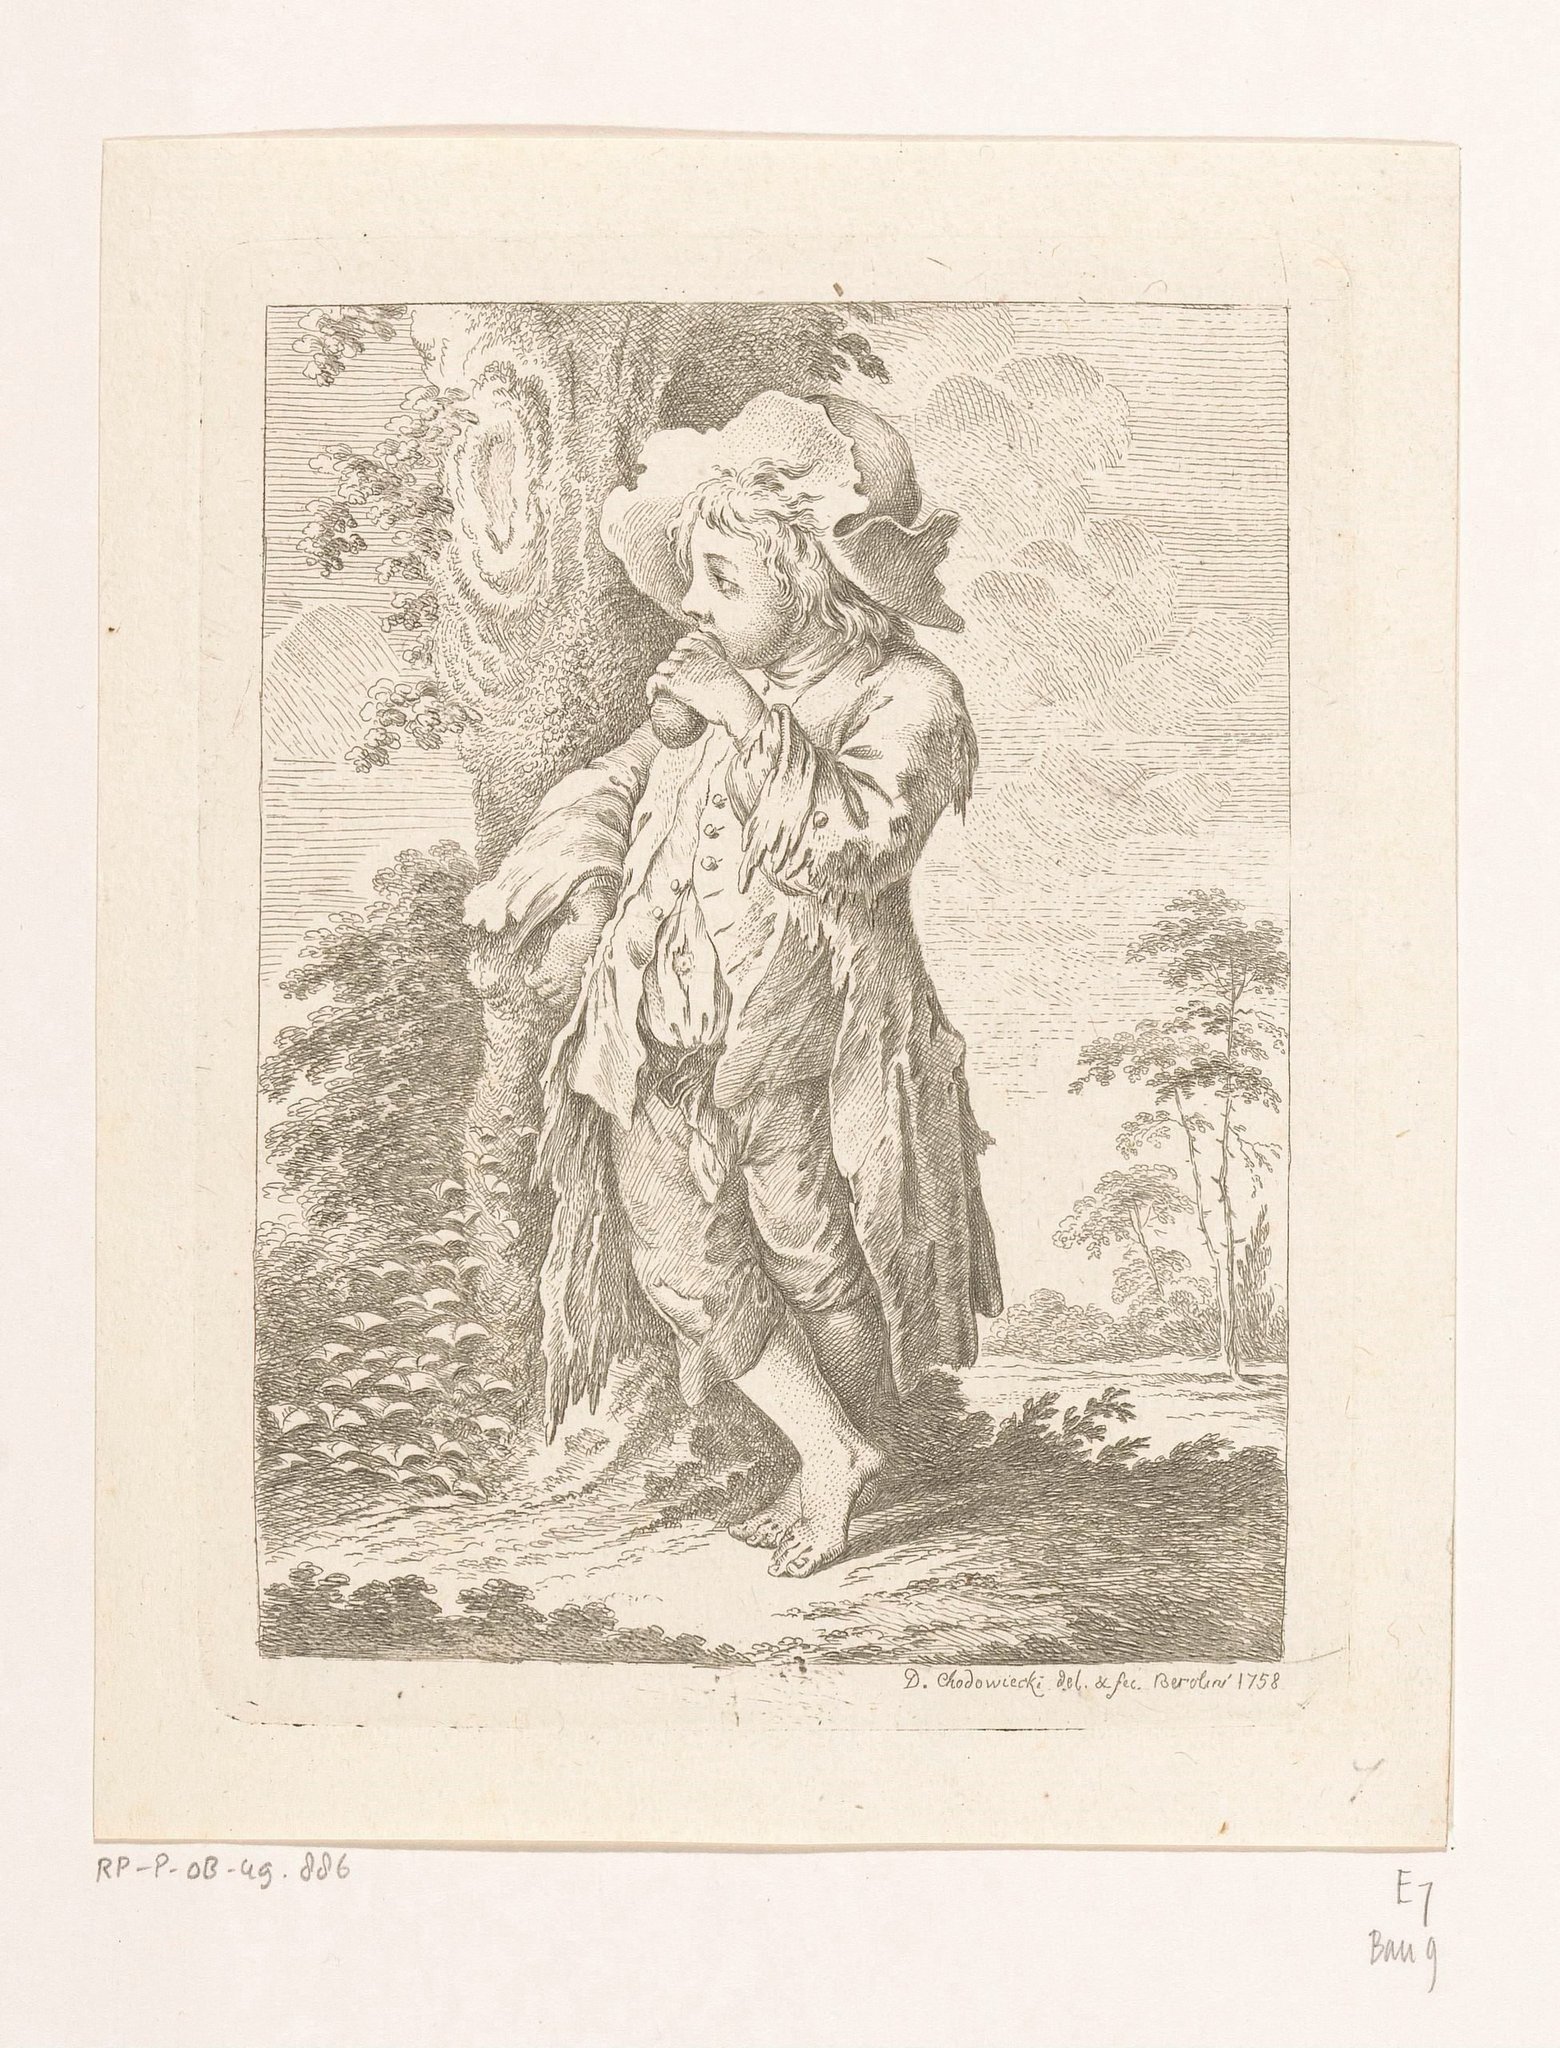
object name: print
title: Bedeljongen bij de boom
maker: daniel nikolaus chodowiecki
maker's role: draughtsman, print maker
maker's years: 1726-1801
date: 1758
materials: paper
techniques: etching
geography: berlin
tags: park, boy (child between toddler and youth), clothed in rags, beggar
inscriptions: collector's mark: Lugt 2228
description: Uit aantekeningen van Chodowiecki is bekend dat de kunstenaar de jongen tekende in het Tiergarten van Berlijn. Opmerkelijk aan de jongen was zijn uitpuilende navel, zichtbaar door een opening in zijn gerafelde kleding.